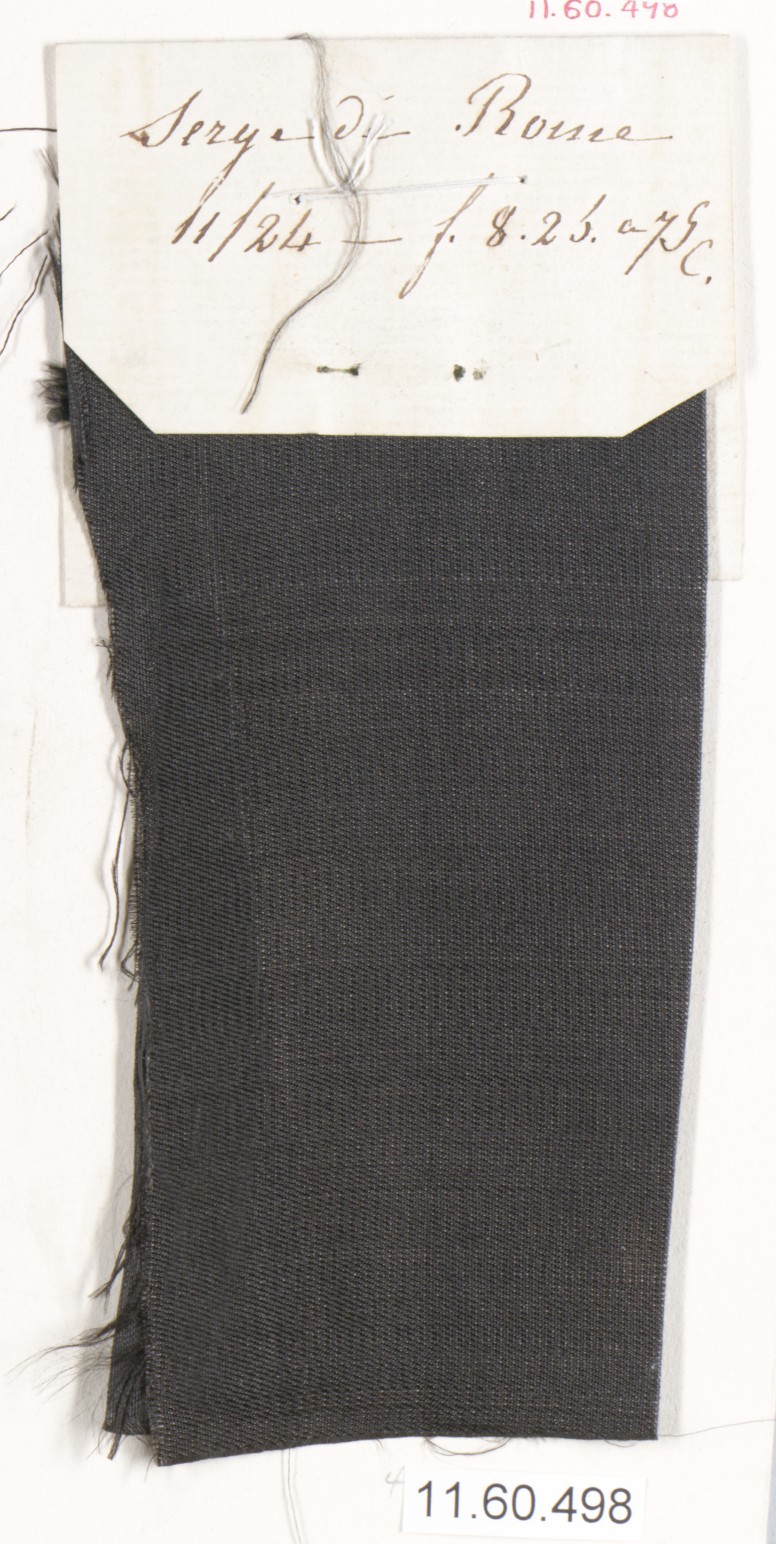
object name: sample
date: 1801-1850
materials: silk